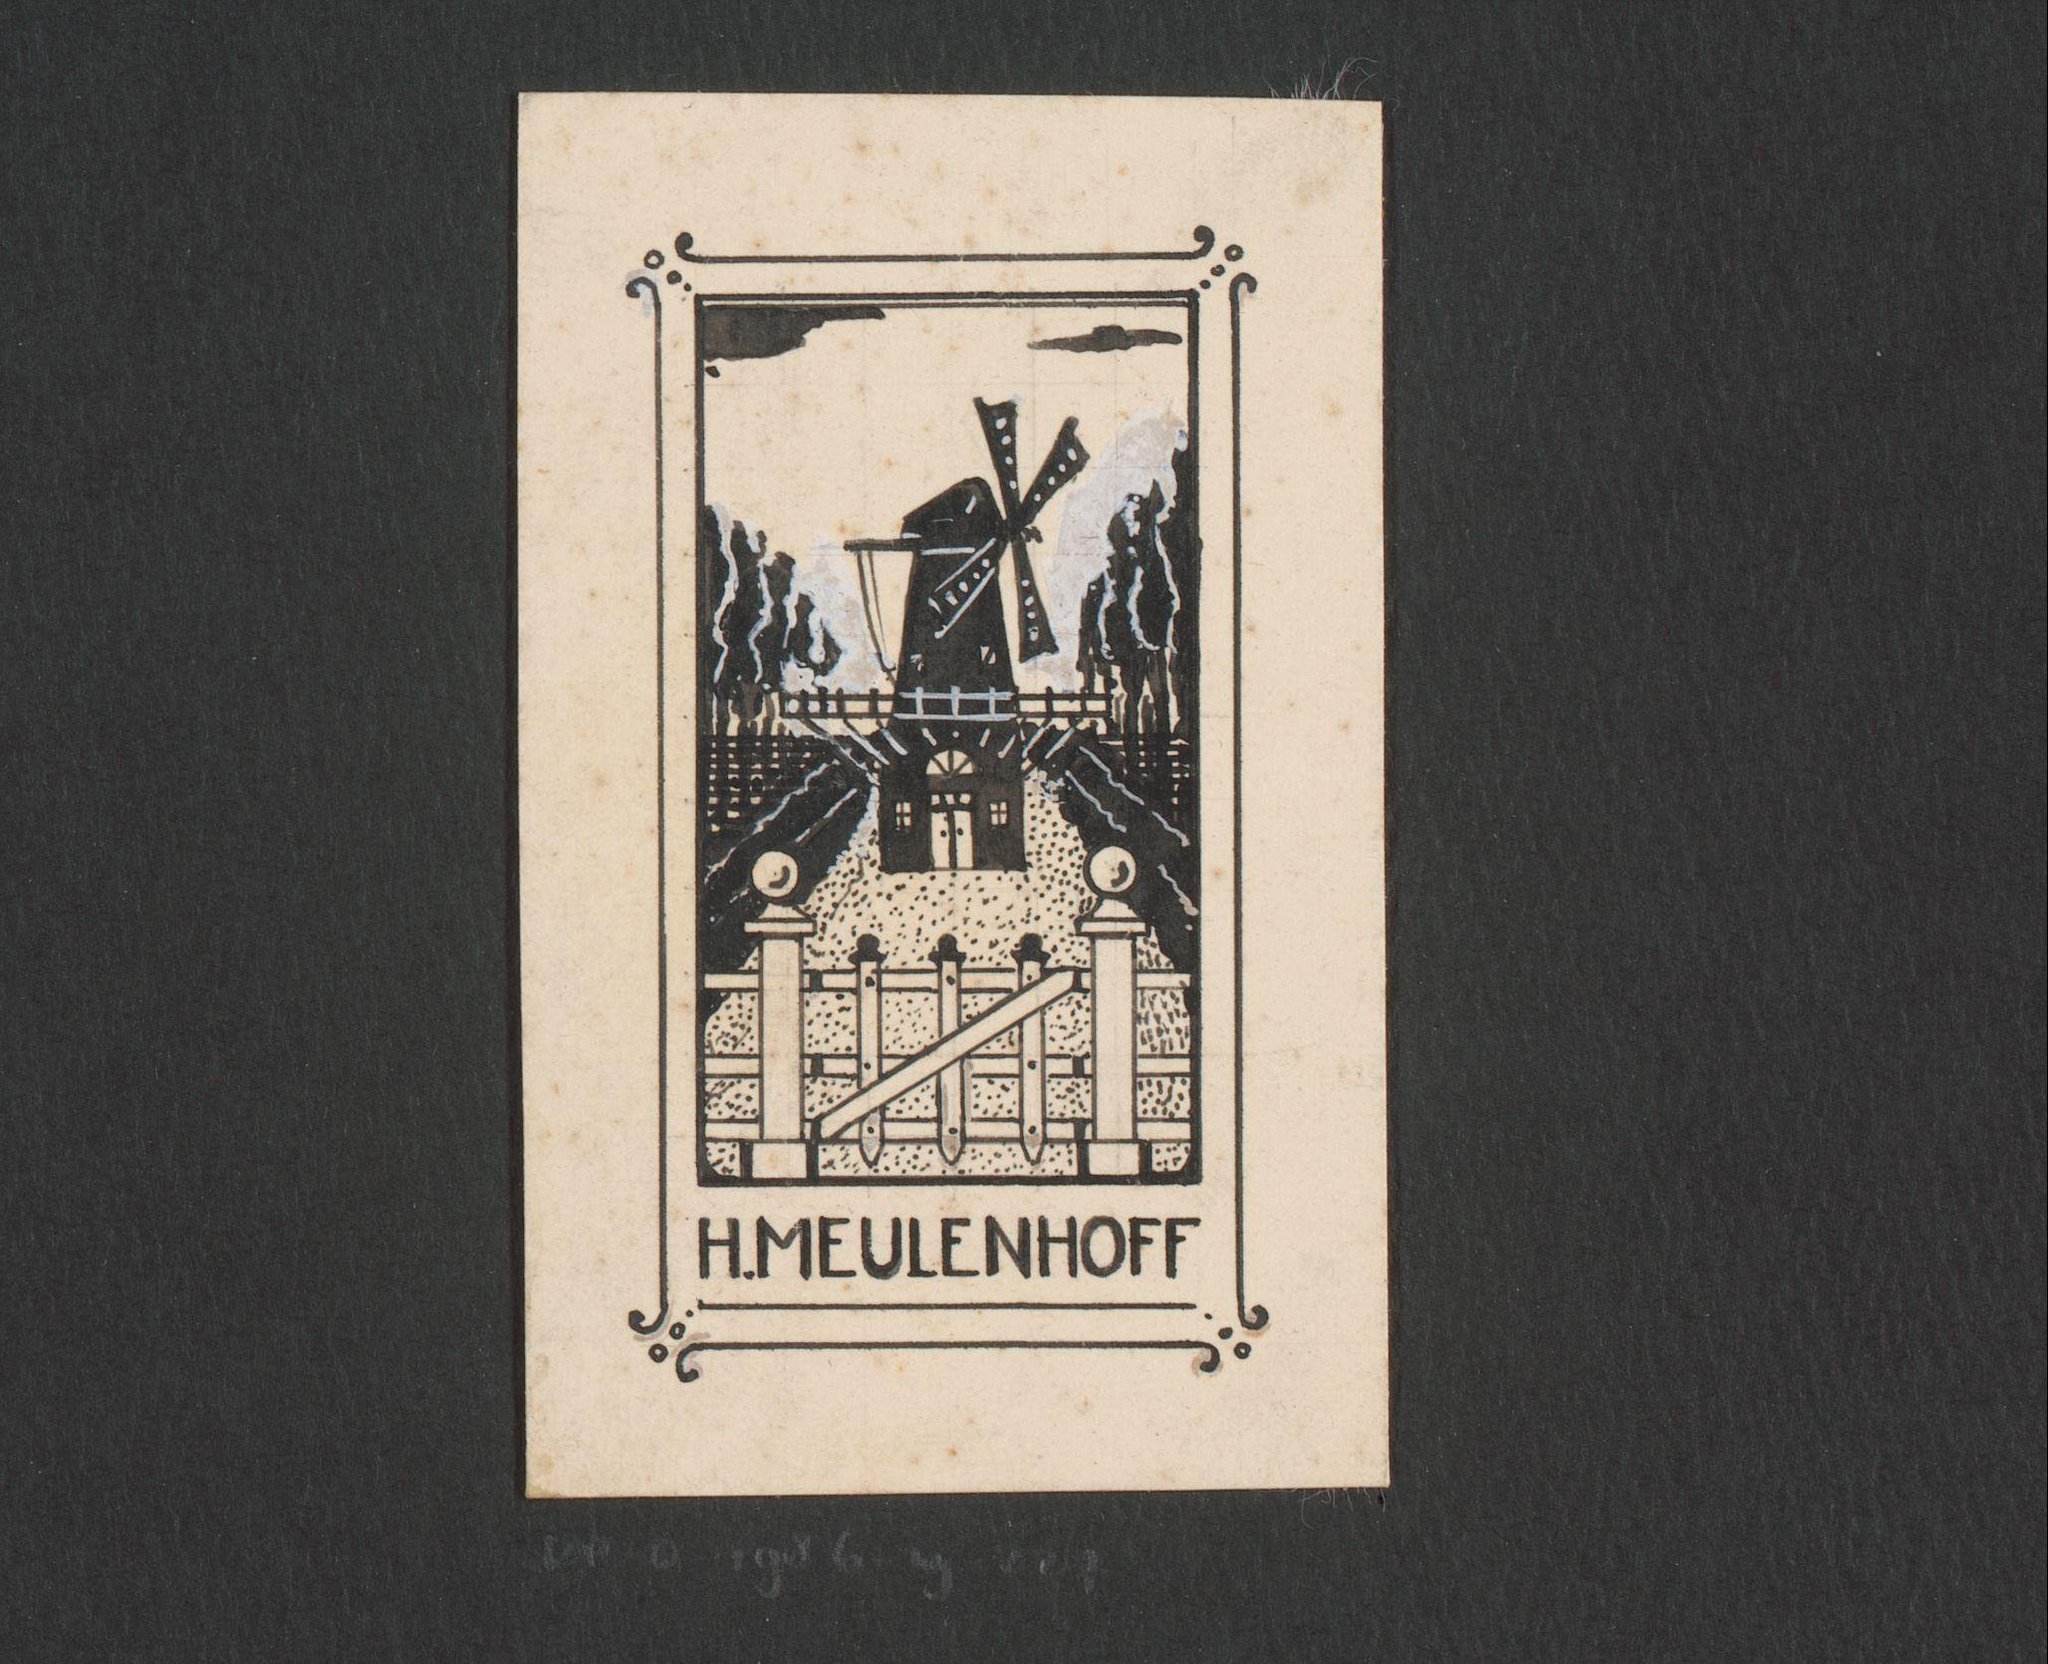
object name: design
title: Ontwerp voor een uitgeversvignet van H. Meulenhoff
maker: reinier willem petrus de vries (1874-1953)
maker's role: draughtsman, print maker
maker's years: 1874-1953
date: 1905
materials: paint, ink, paper, pencil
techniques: brush, pen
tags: fence, wall, paling, windmill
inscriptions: collector's mark: ‘R:MVS.’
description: Molen op een pad met aan weerszijden een bomenrij. Op de voorgrond een hek.